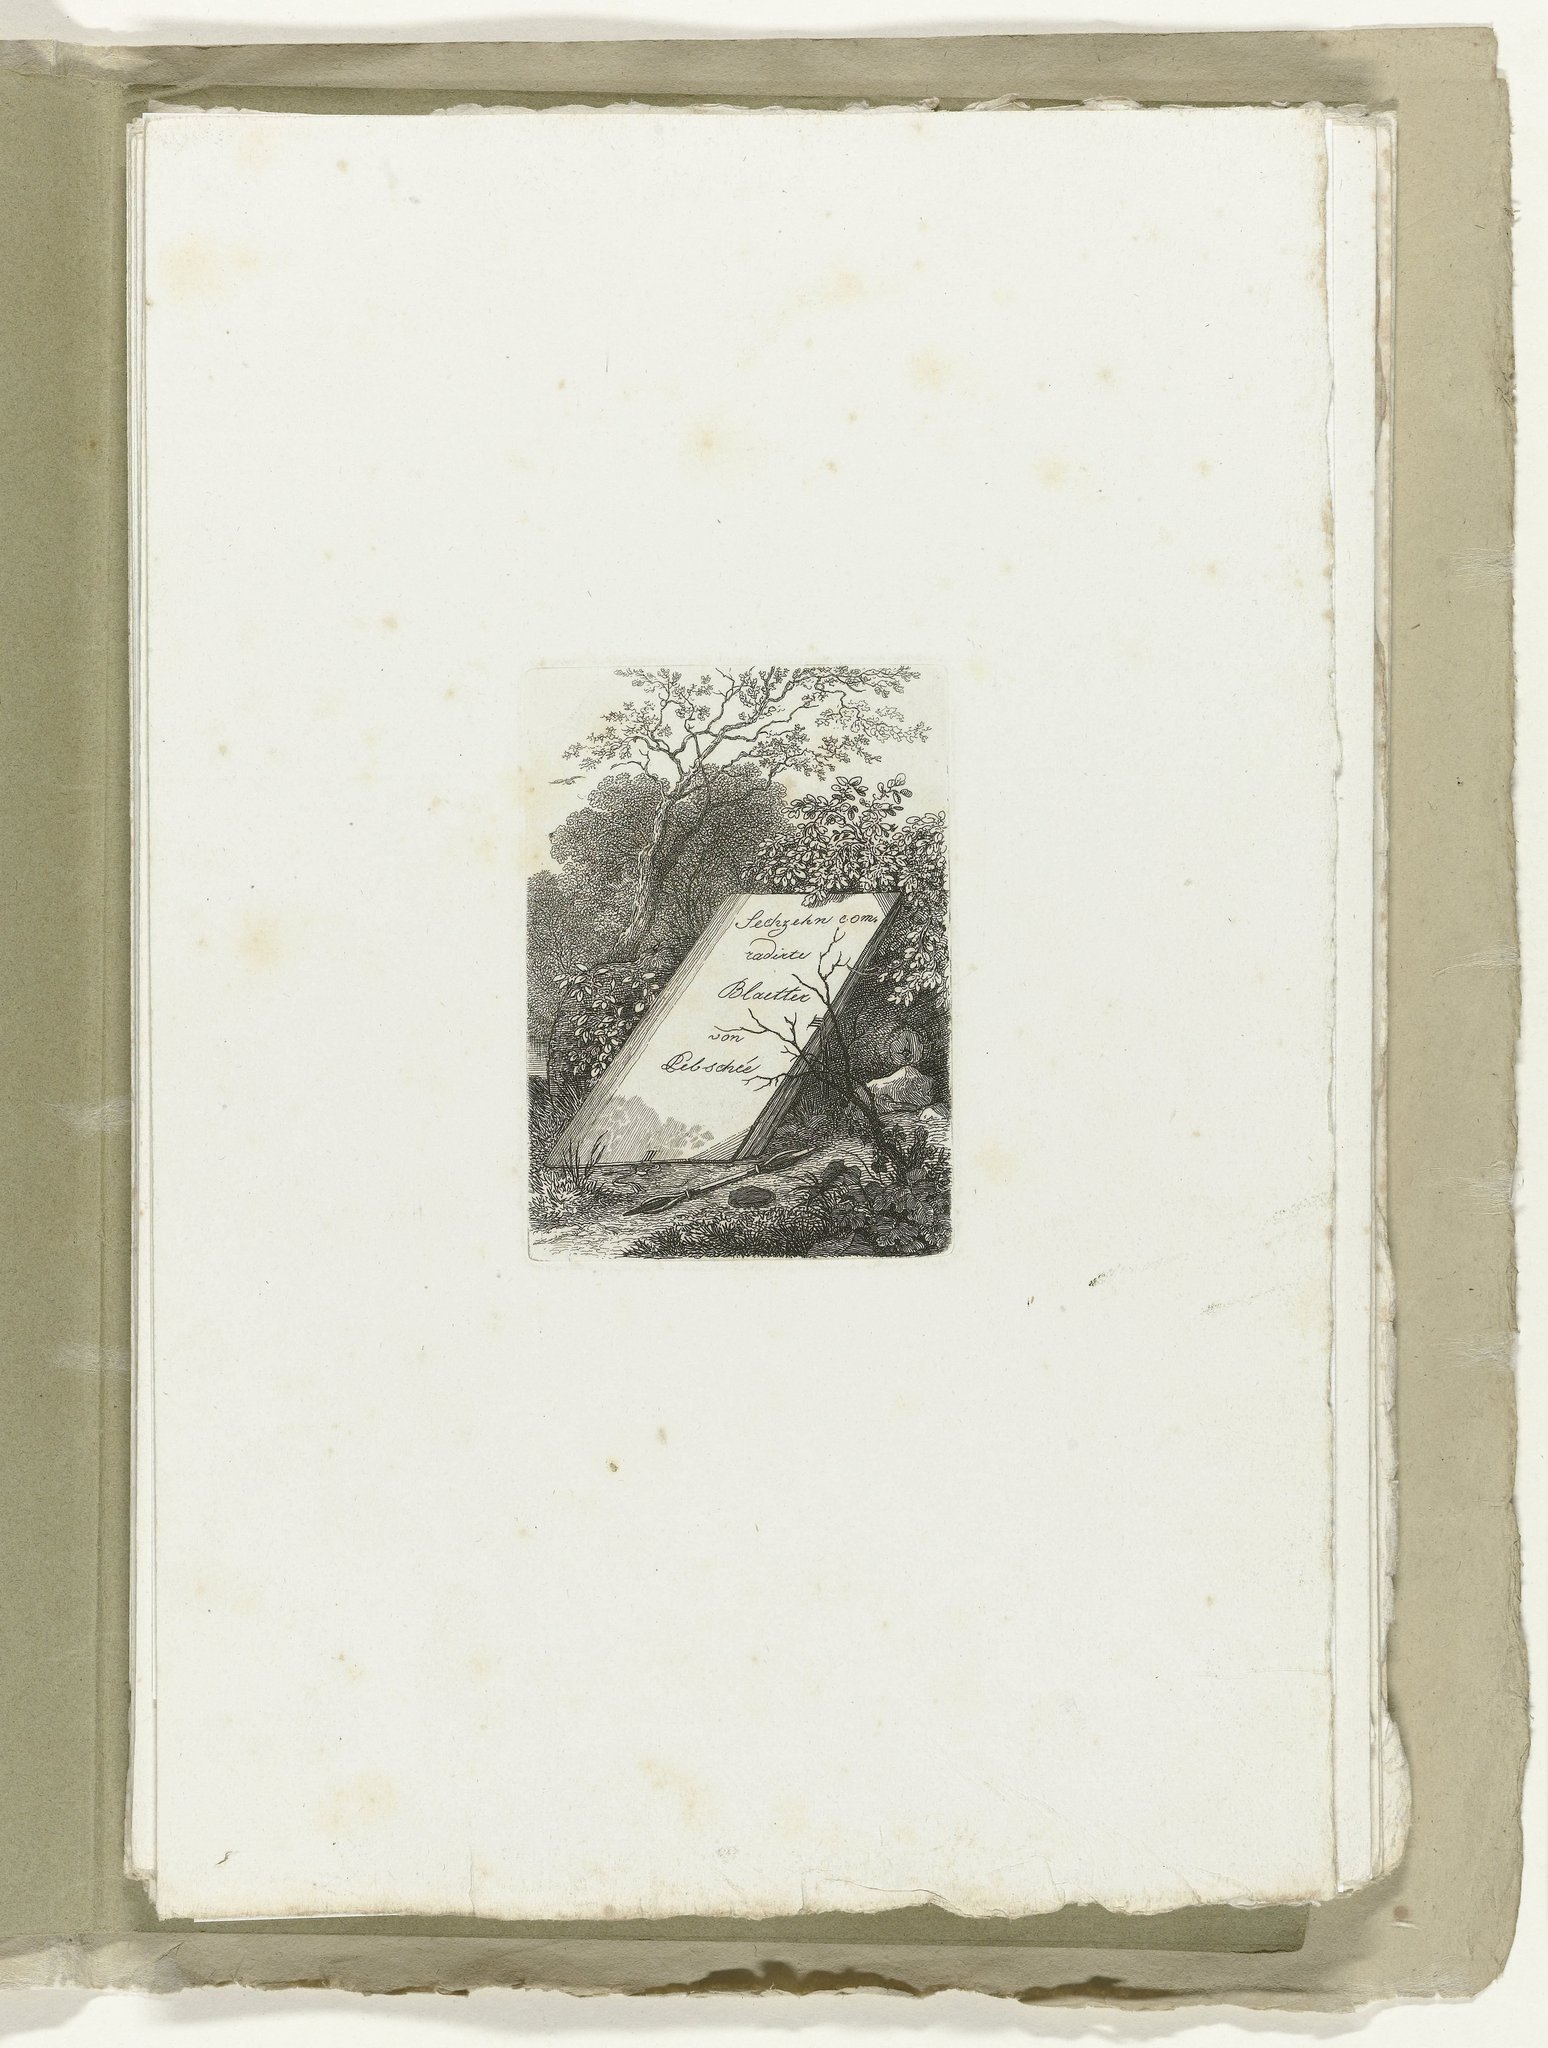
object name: print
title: Bosgezicht met boek en etsnaald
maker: carl august lebschee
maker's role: draughtsman, painter, print maker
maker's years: 1800-1877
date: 1827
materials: paper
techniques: etching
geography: munich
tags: tools, implements of graphic artist, book, forest, wood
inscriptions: collector's mark: Lugt 2760, collector's mark: Lugt 2228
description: Deze prent maakt deel uit van een dubbel omslag.